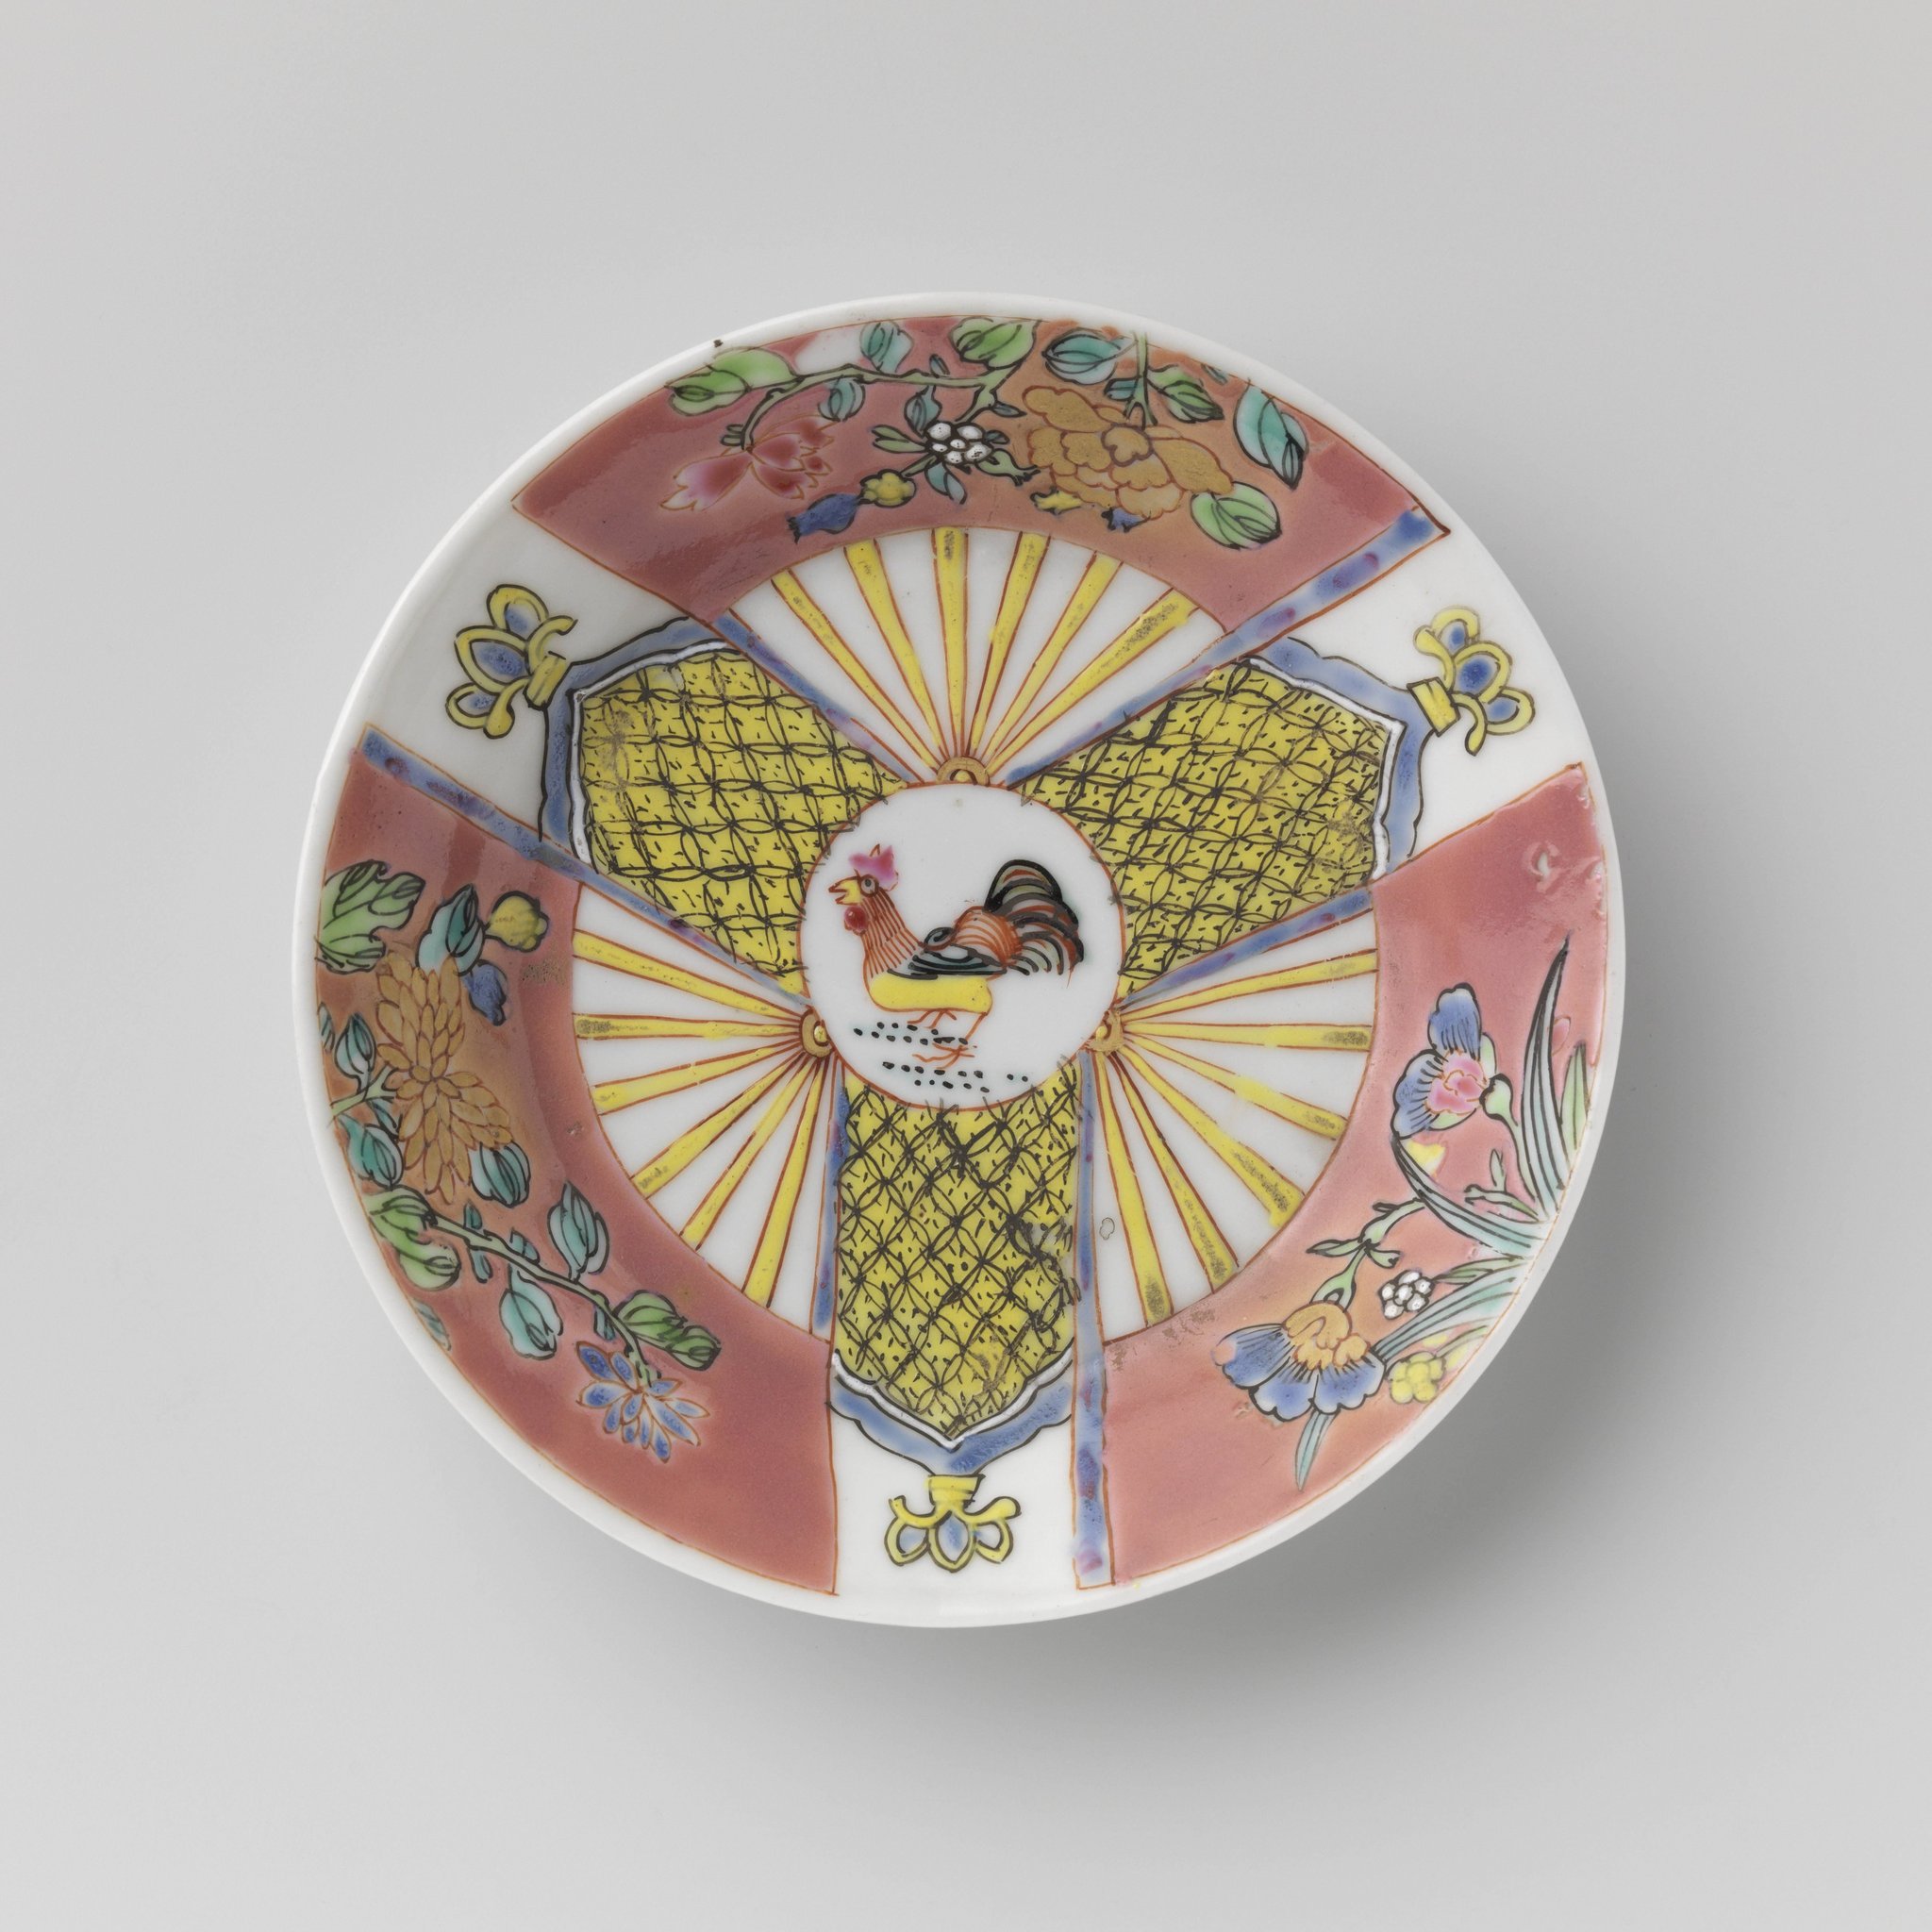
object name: platter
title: Saucer with cock and three fans with flower sprays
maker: Anonymous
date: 1725-1749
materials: glaze, gold, paint, porcelain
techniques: firing, gilding, turning, vitrification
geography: china